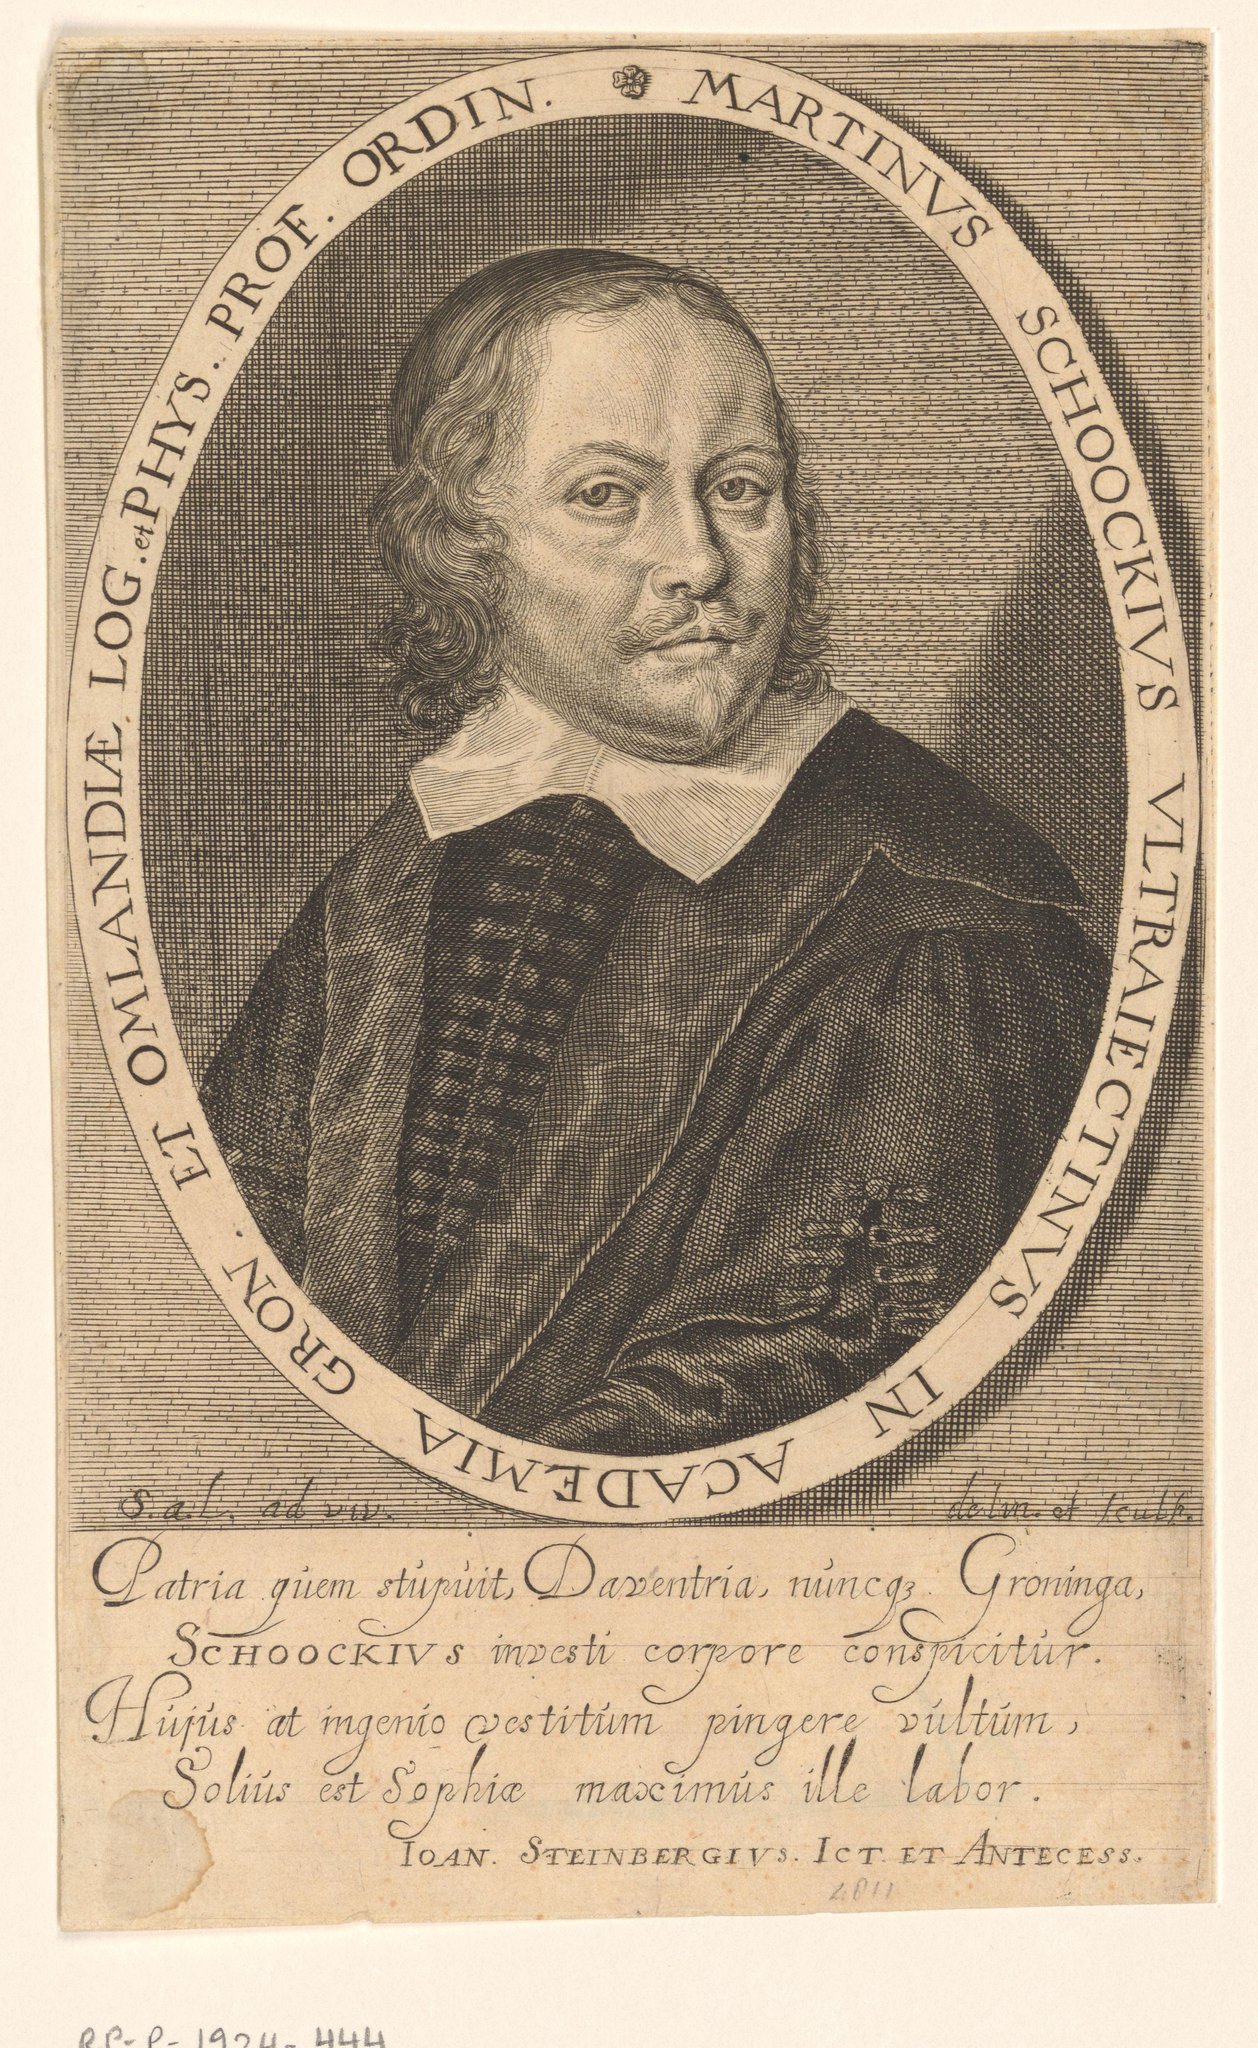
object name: print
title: Portret van Martinus Schoock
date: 1654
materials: paper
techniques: engraving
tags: martinus schoock, historical persons, portrait of a writer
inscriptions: collector's mark: Lugt 2233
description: Prent met tekst op verso gebruikt in: Effigies & vitae Professorvm Academiae Groningae & Omlandiae. Groningen: Johannes Nicolai, 1654.